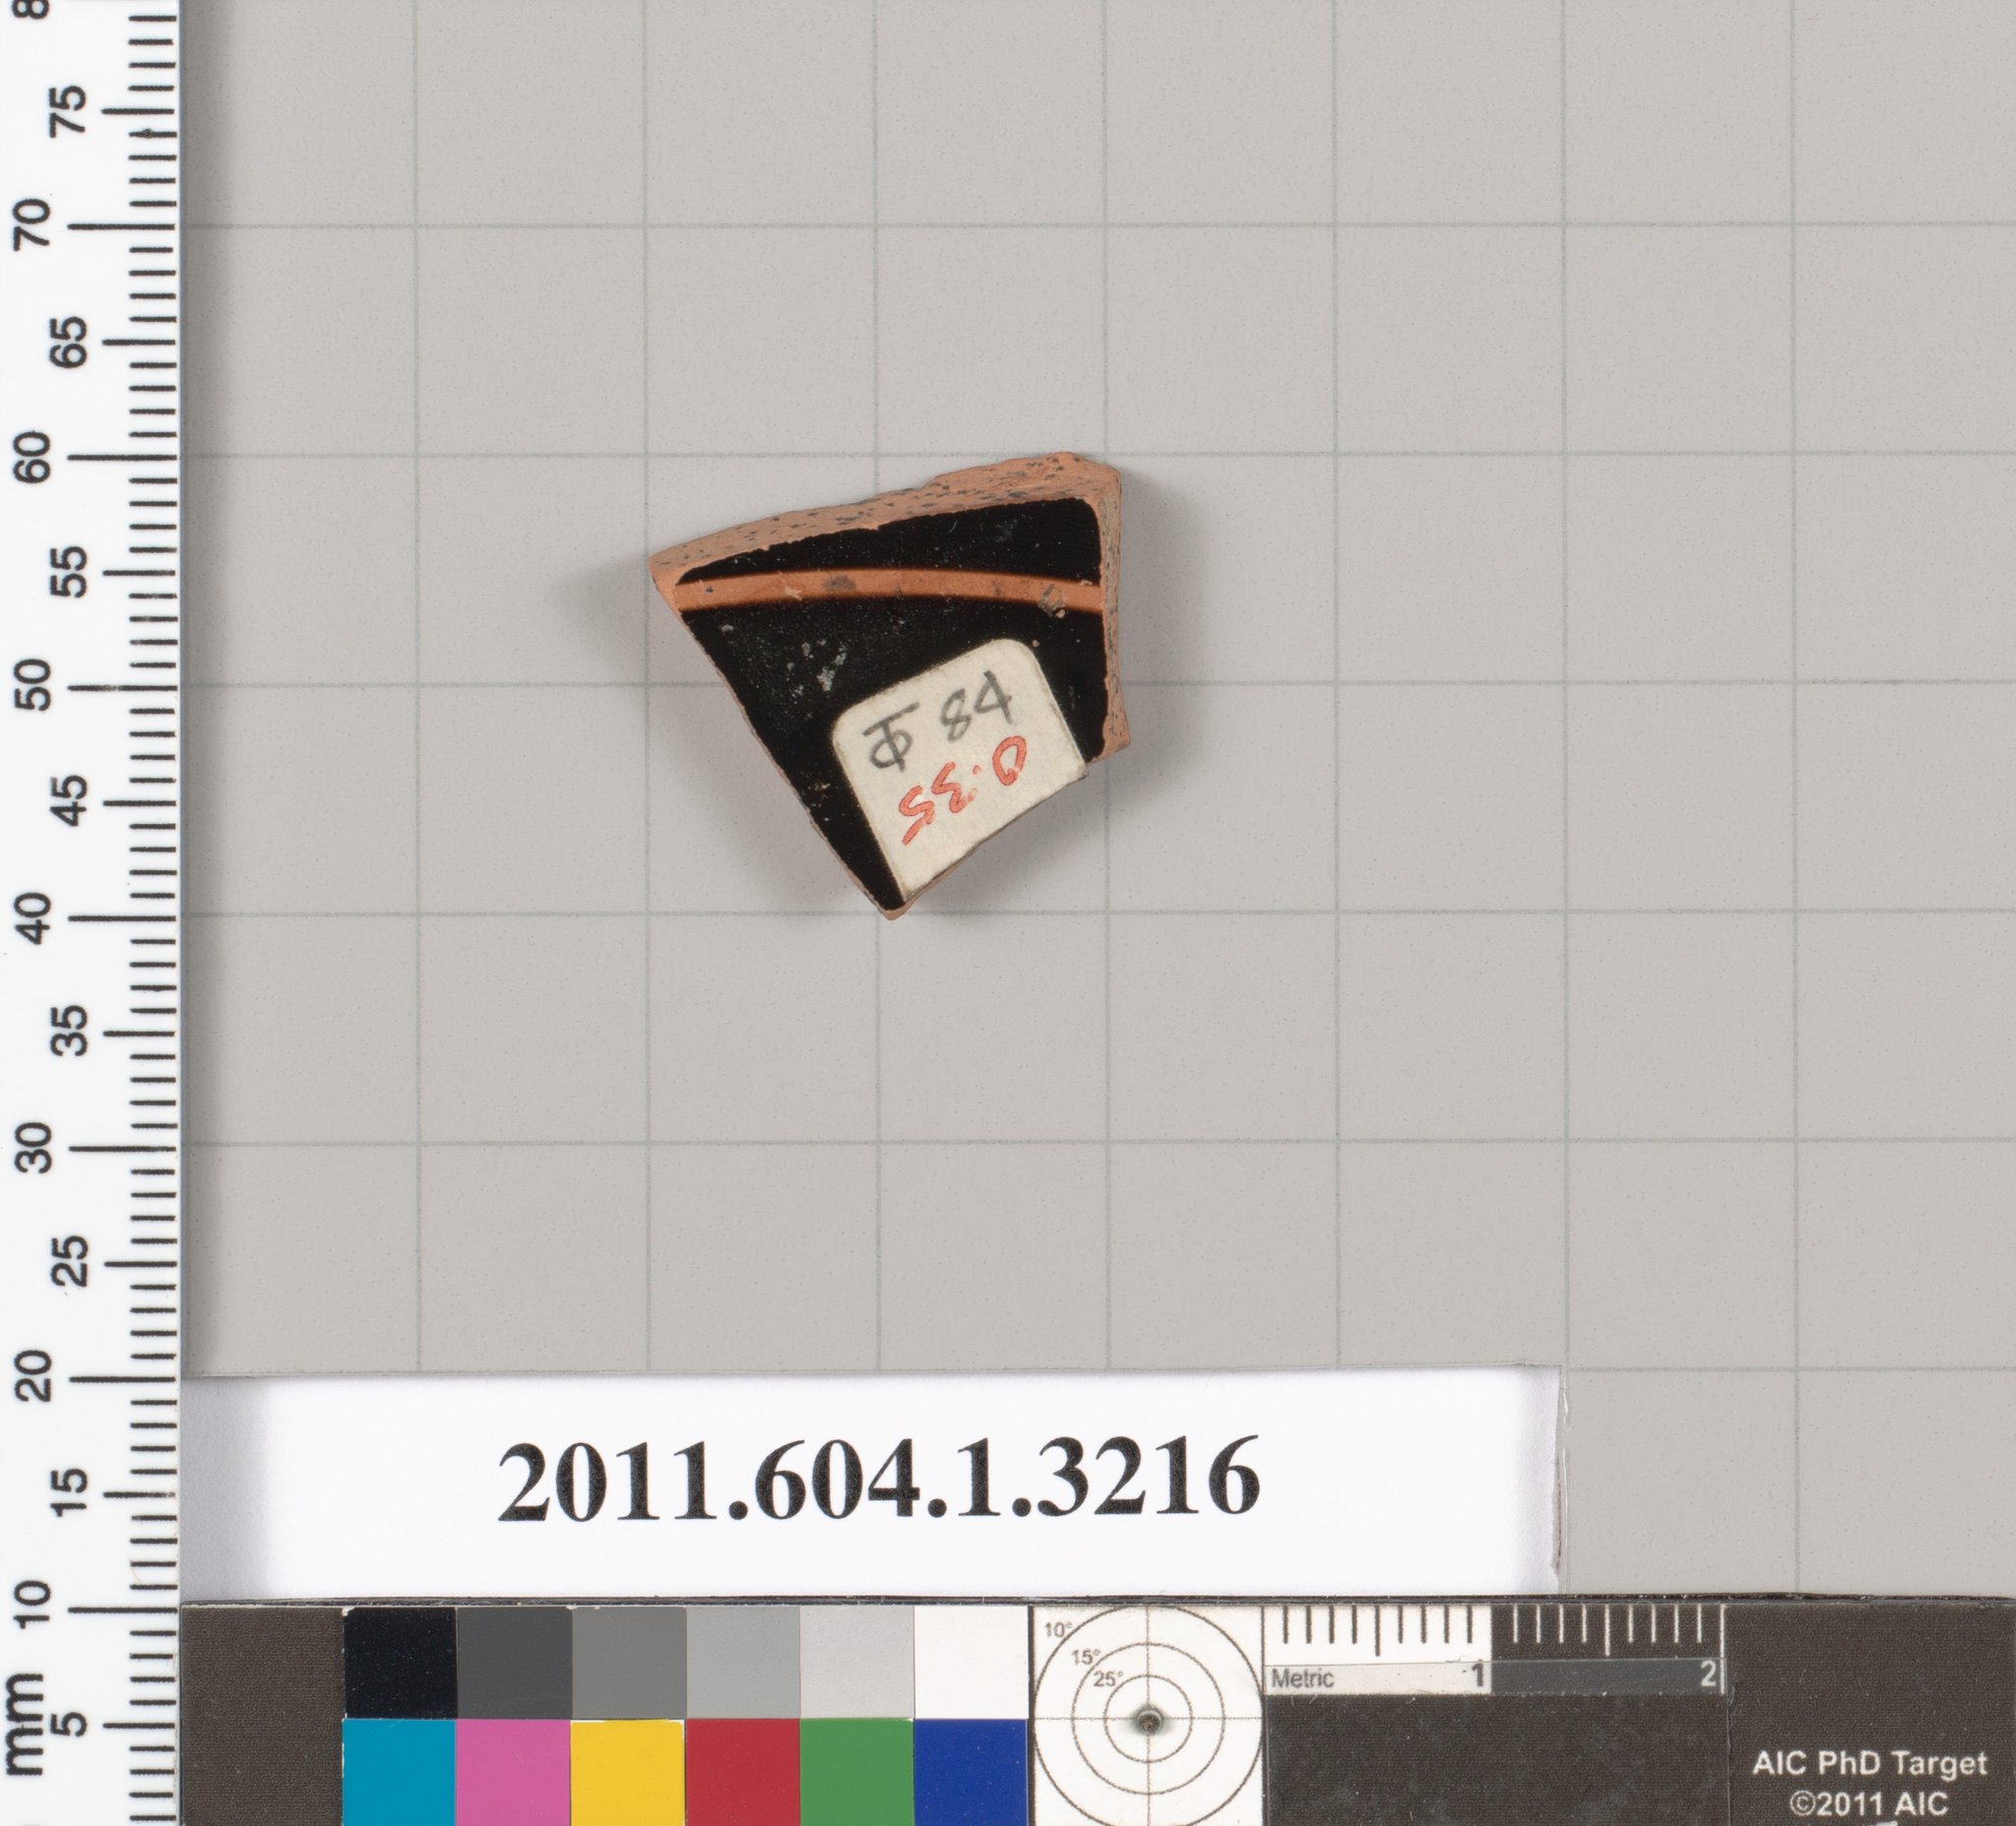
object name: kylix fragment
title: Terracotta fragment of a kylix (drinking cup)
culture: greek, attic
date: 500-451 BCE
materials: terracotta